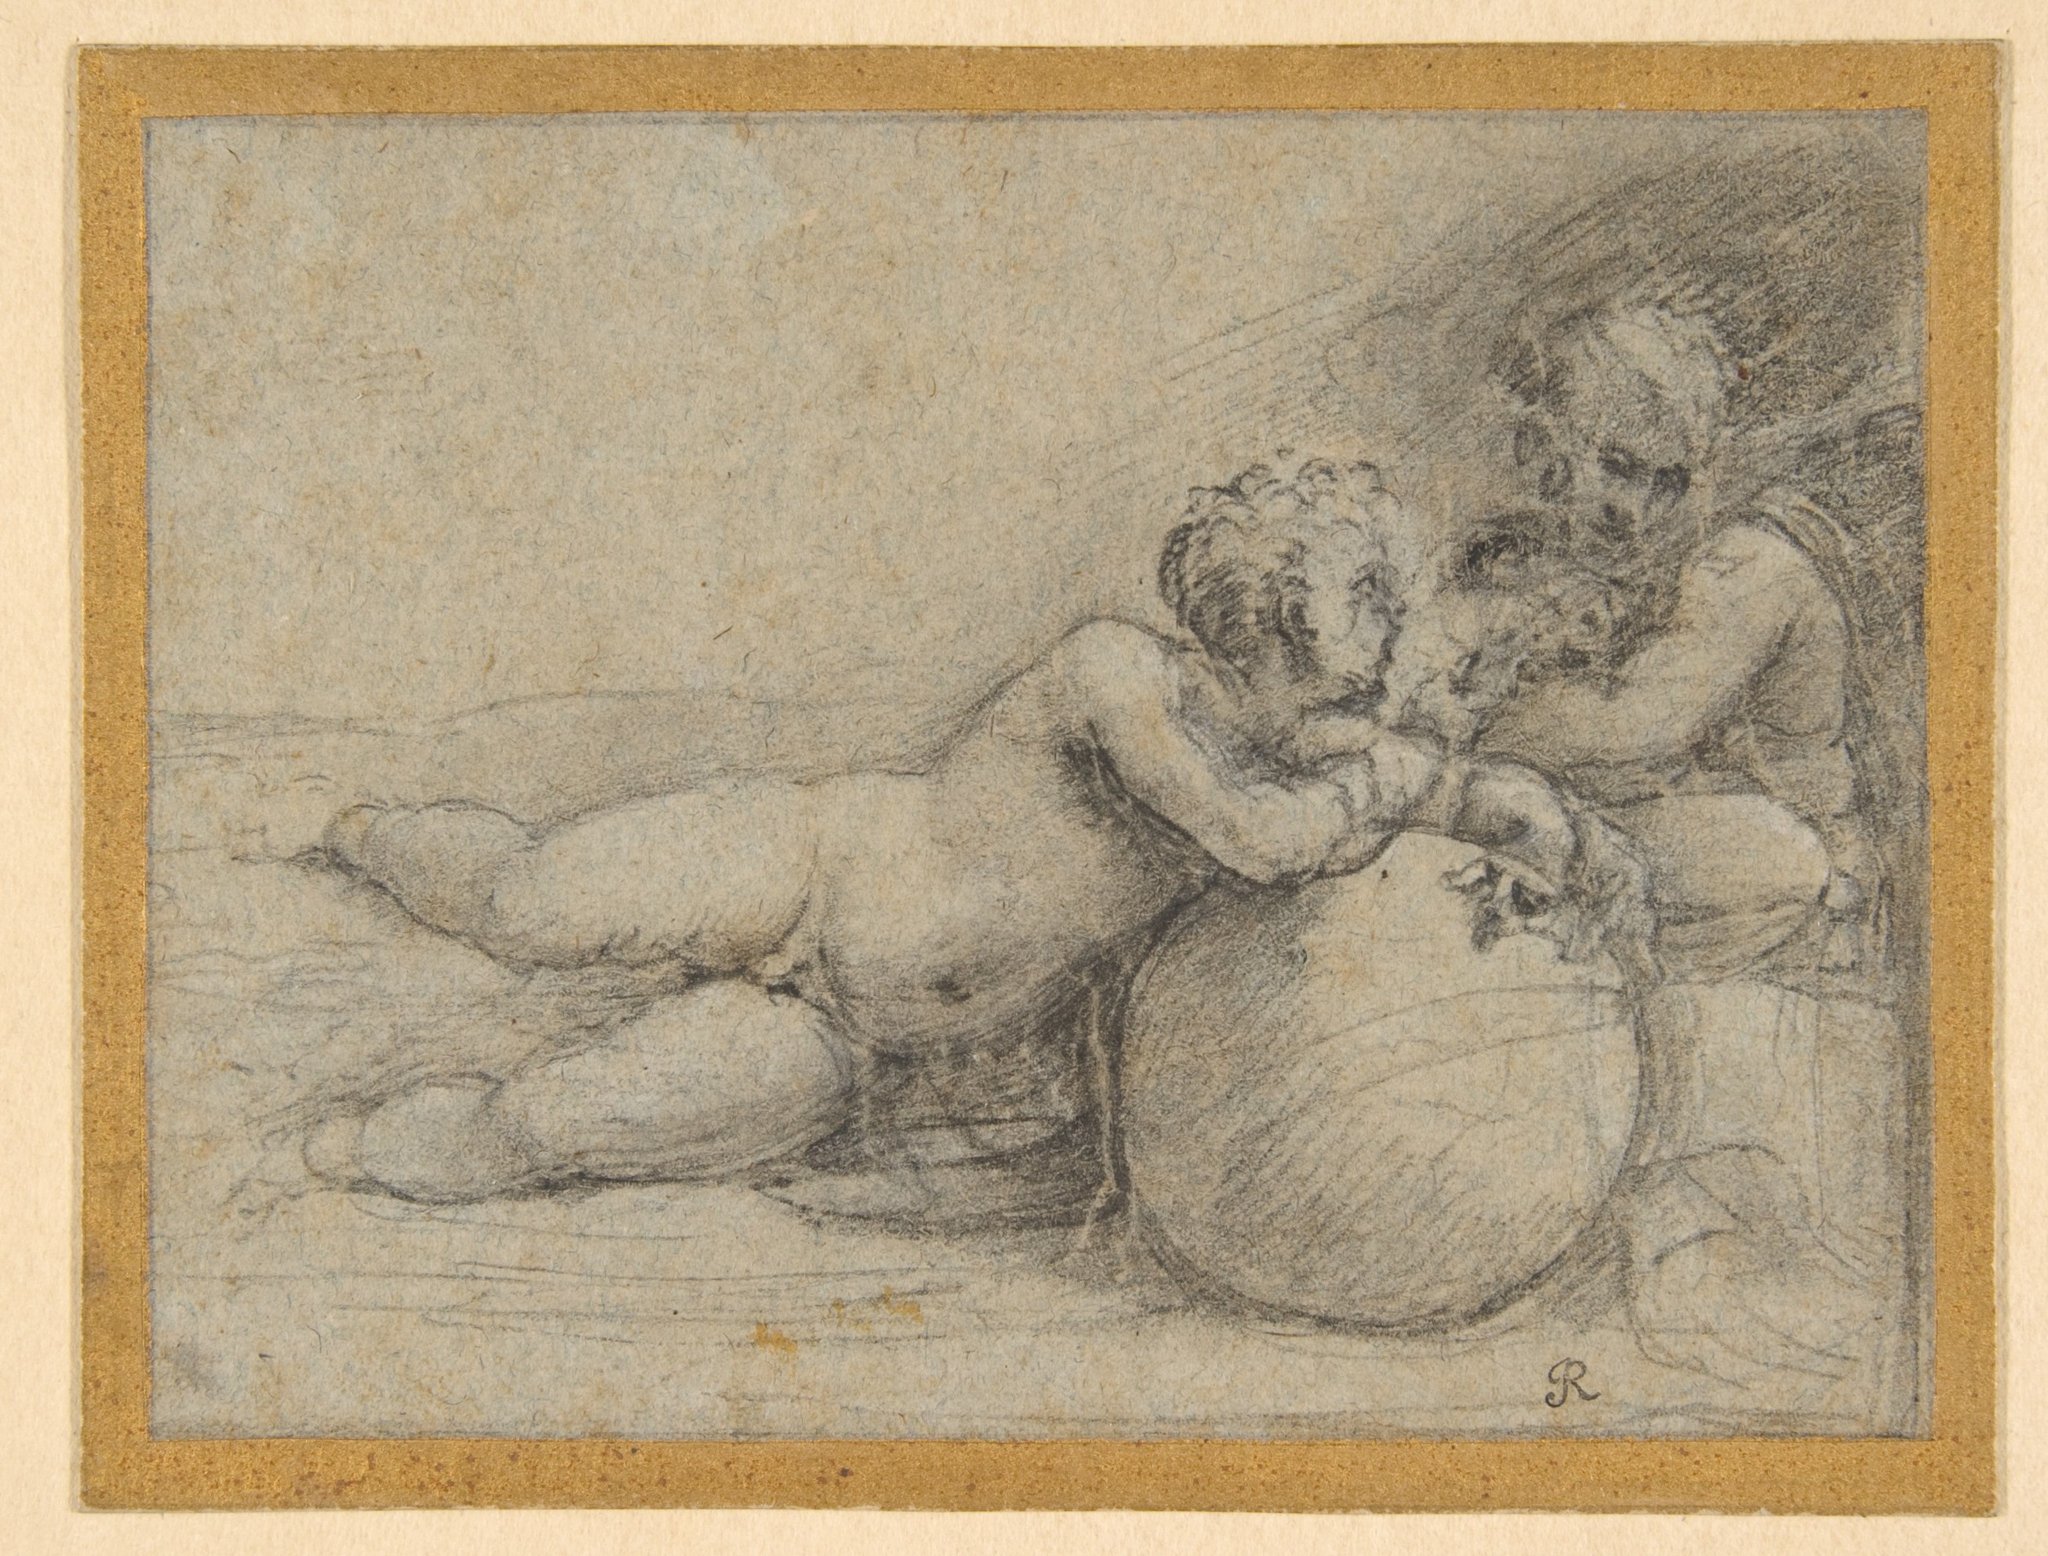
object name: drawing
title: The Christ Child and Saint John the Baptist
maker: sebastiano del piombo (sebastiano luciani)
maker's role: artist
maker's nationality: italian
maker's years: 1485-1547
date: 1485-1547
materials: chalk, paper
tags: christ,saint john the baptist